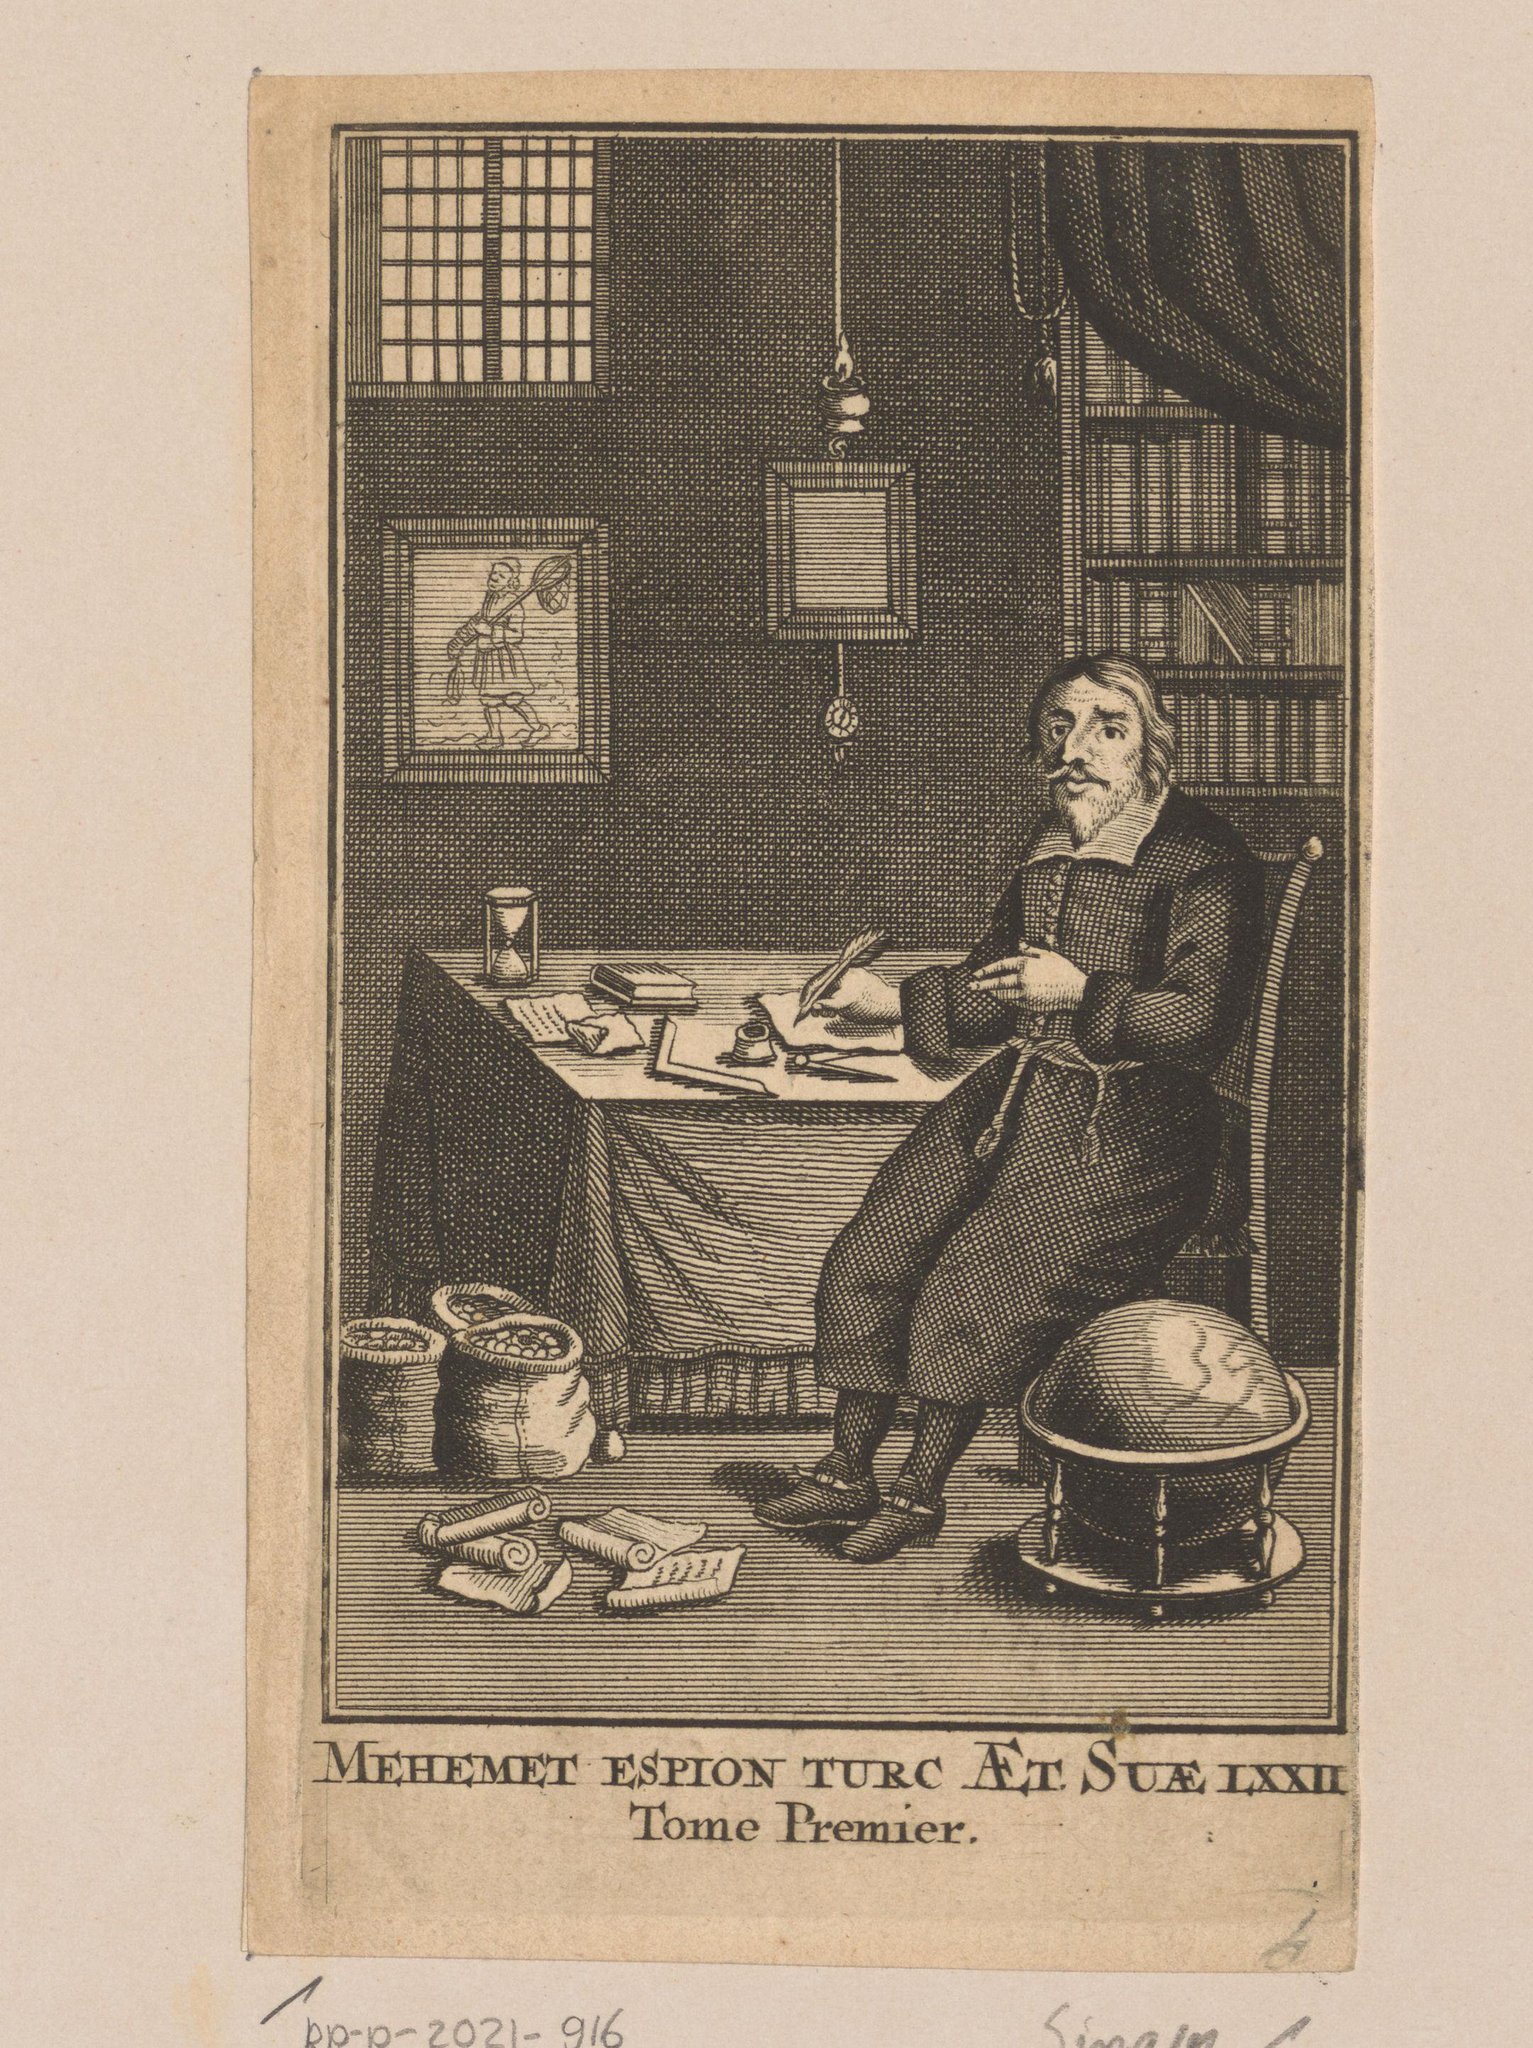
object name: print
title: Portret van een onbekende Turkse man op 72-jarige leeftijd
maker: Anonymous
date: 1650-1750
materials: paper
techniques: engraving, etching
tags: (military) espionage, historical persons, head-gear: turban, study; 'studiolo'; library